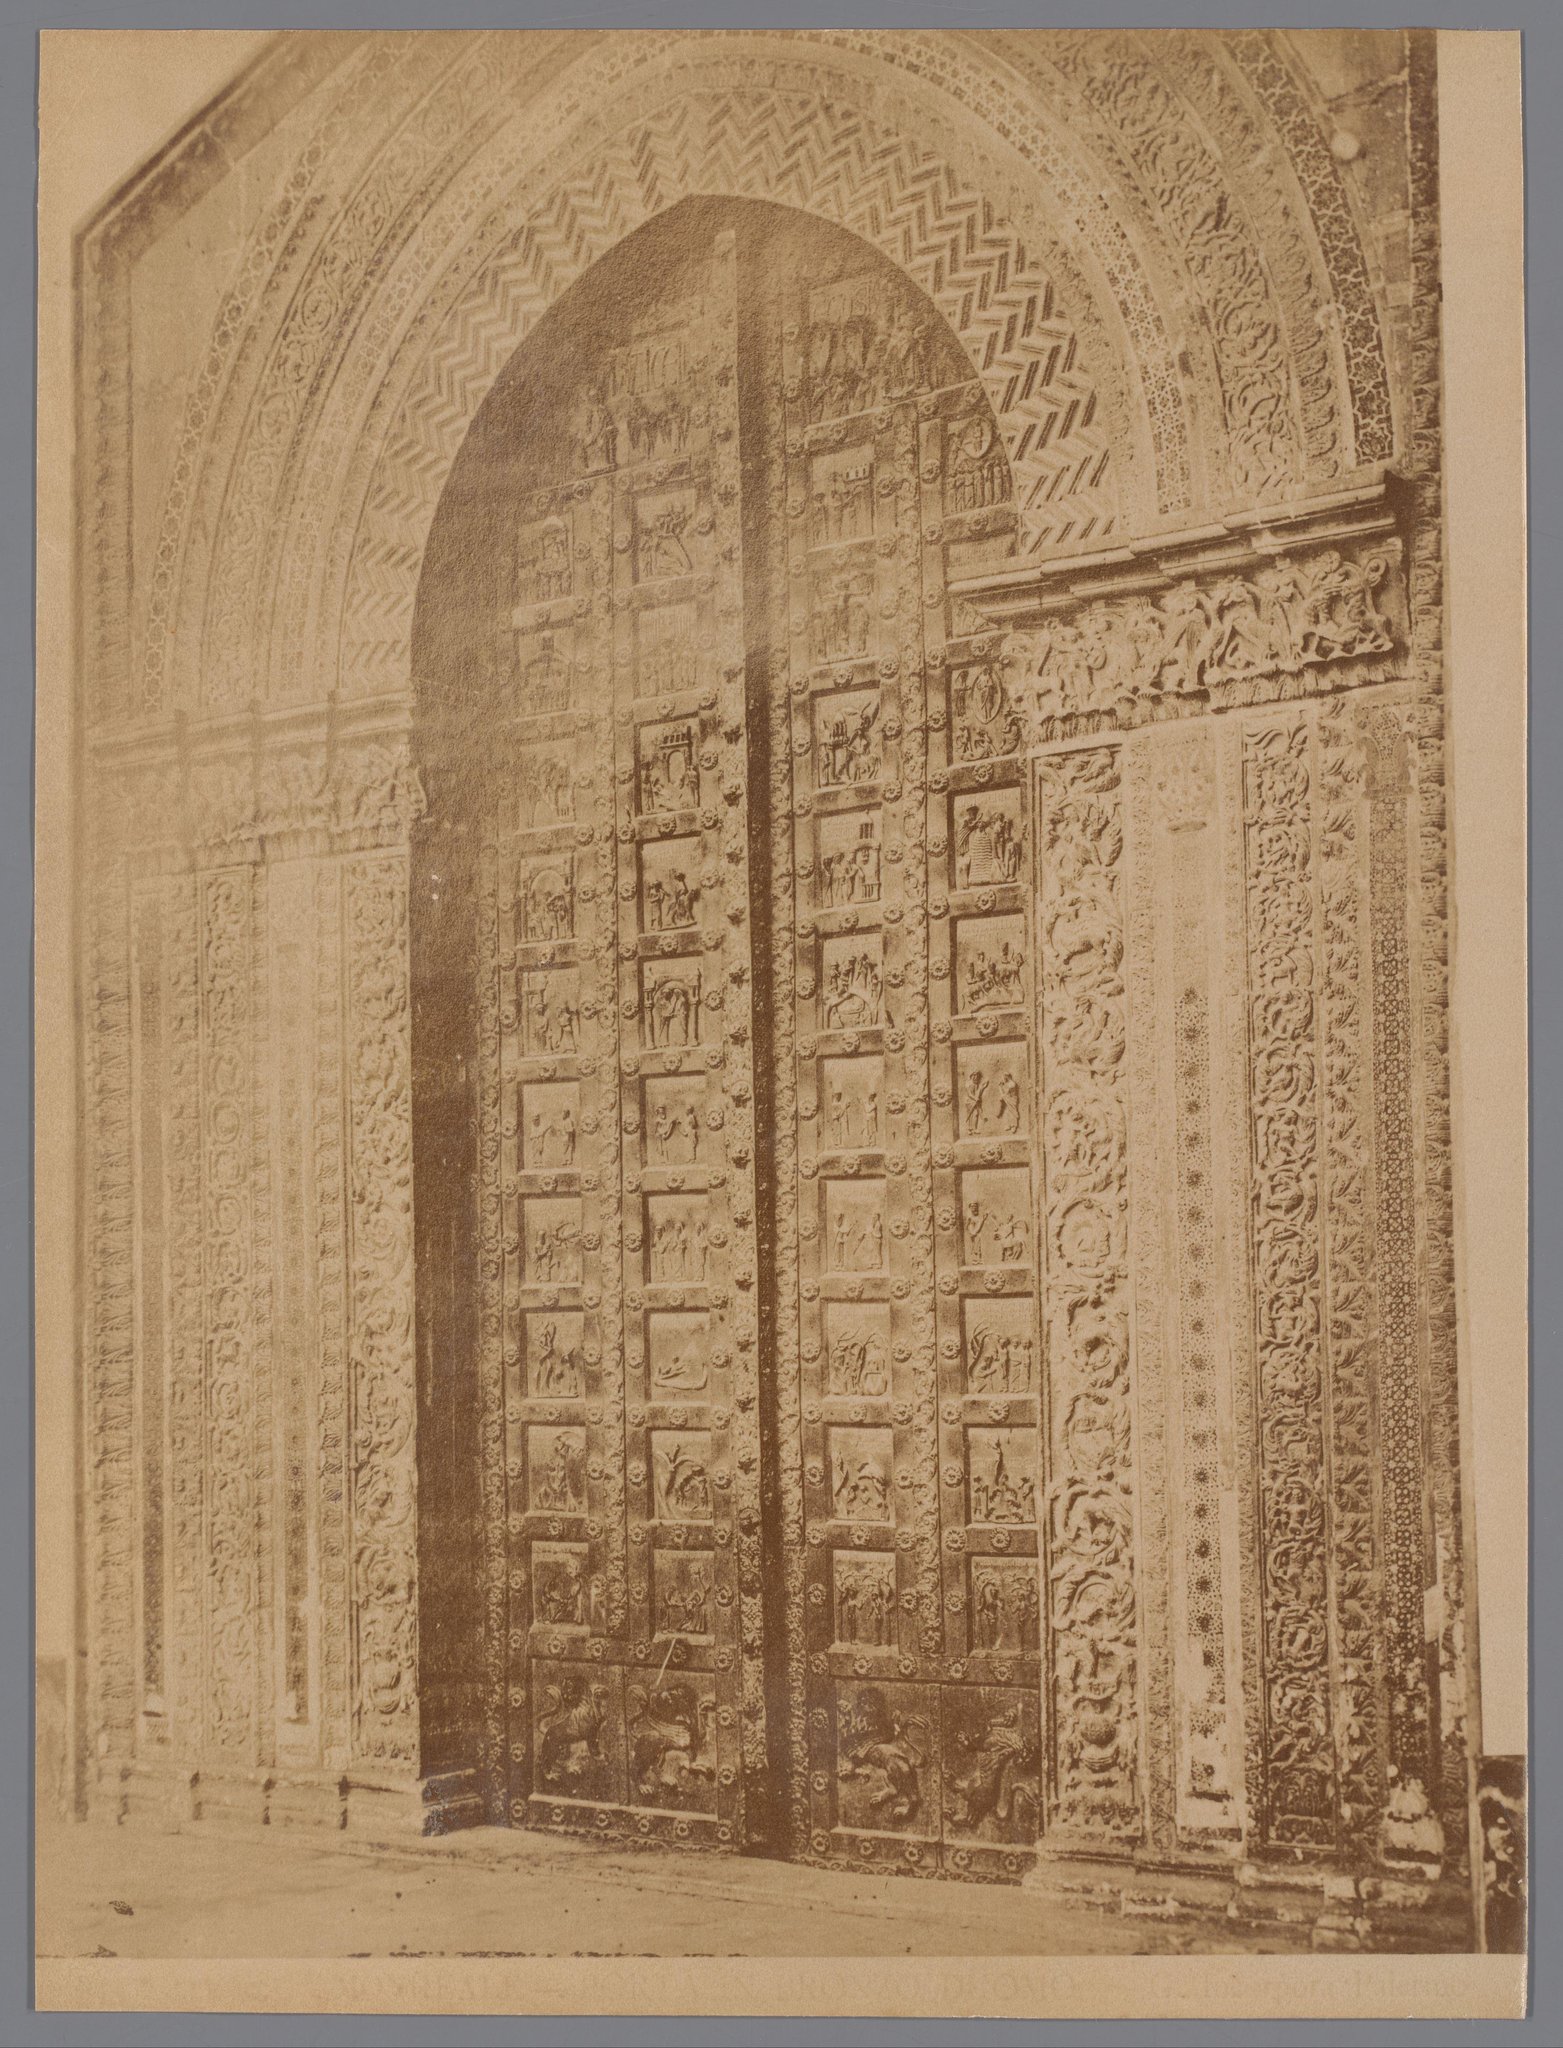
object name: photograph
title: Bronzen portaal van de dom van Monreale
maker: giuseppe incorpora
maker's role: fotograaf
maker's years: 1834-1914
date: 1860-1900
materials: paper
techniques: albumen print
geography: monreale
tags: parts of church exterior and annexes: portal